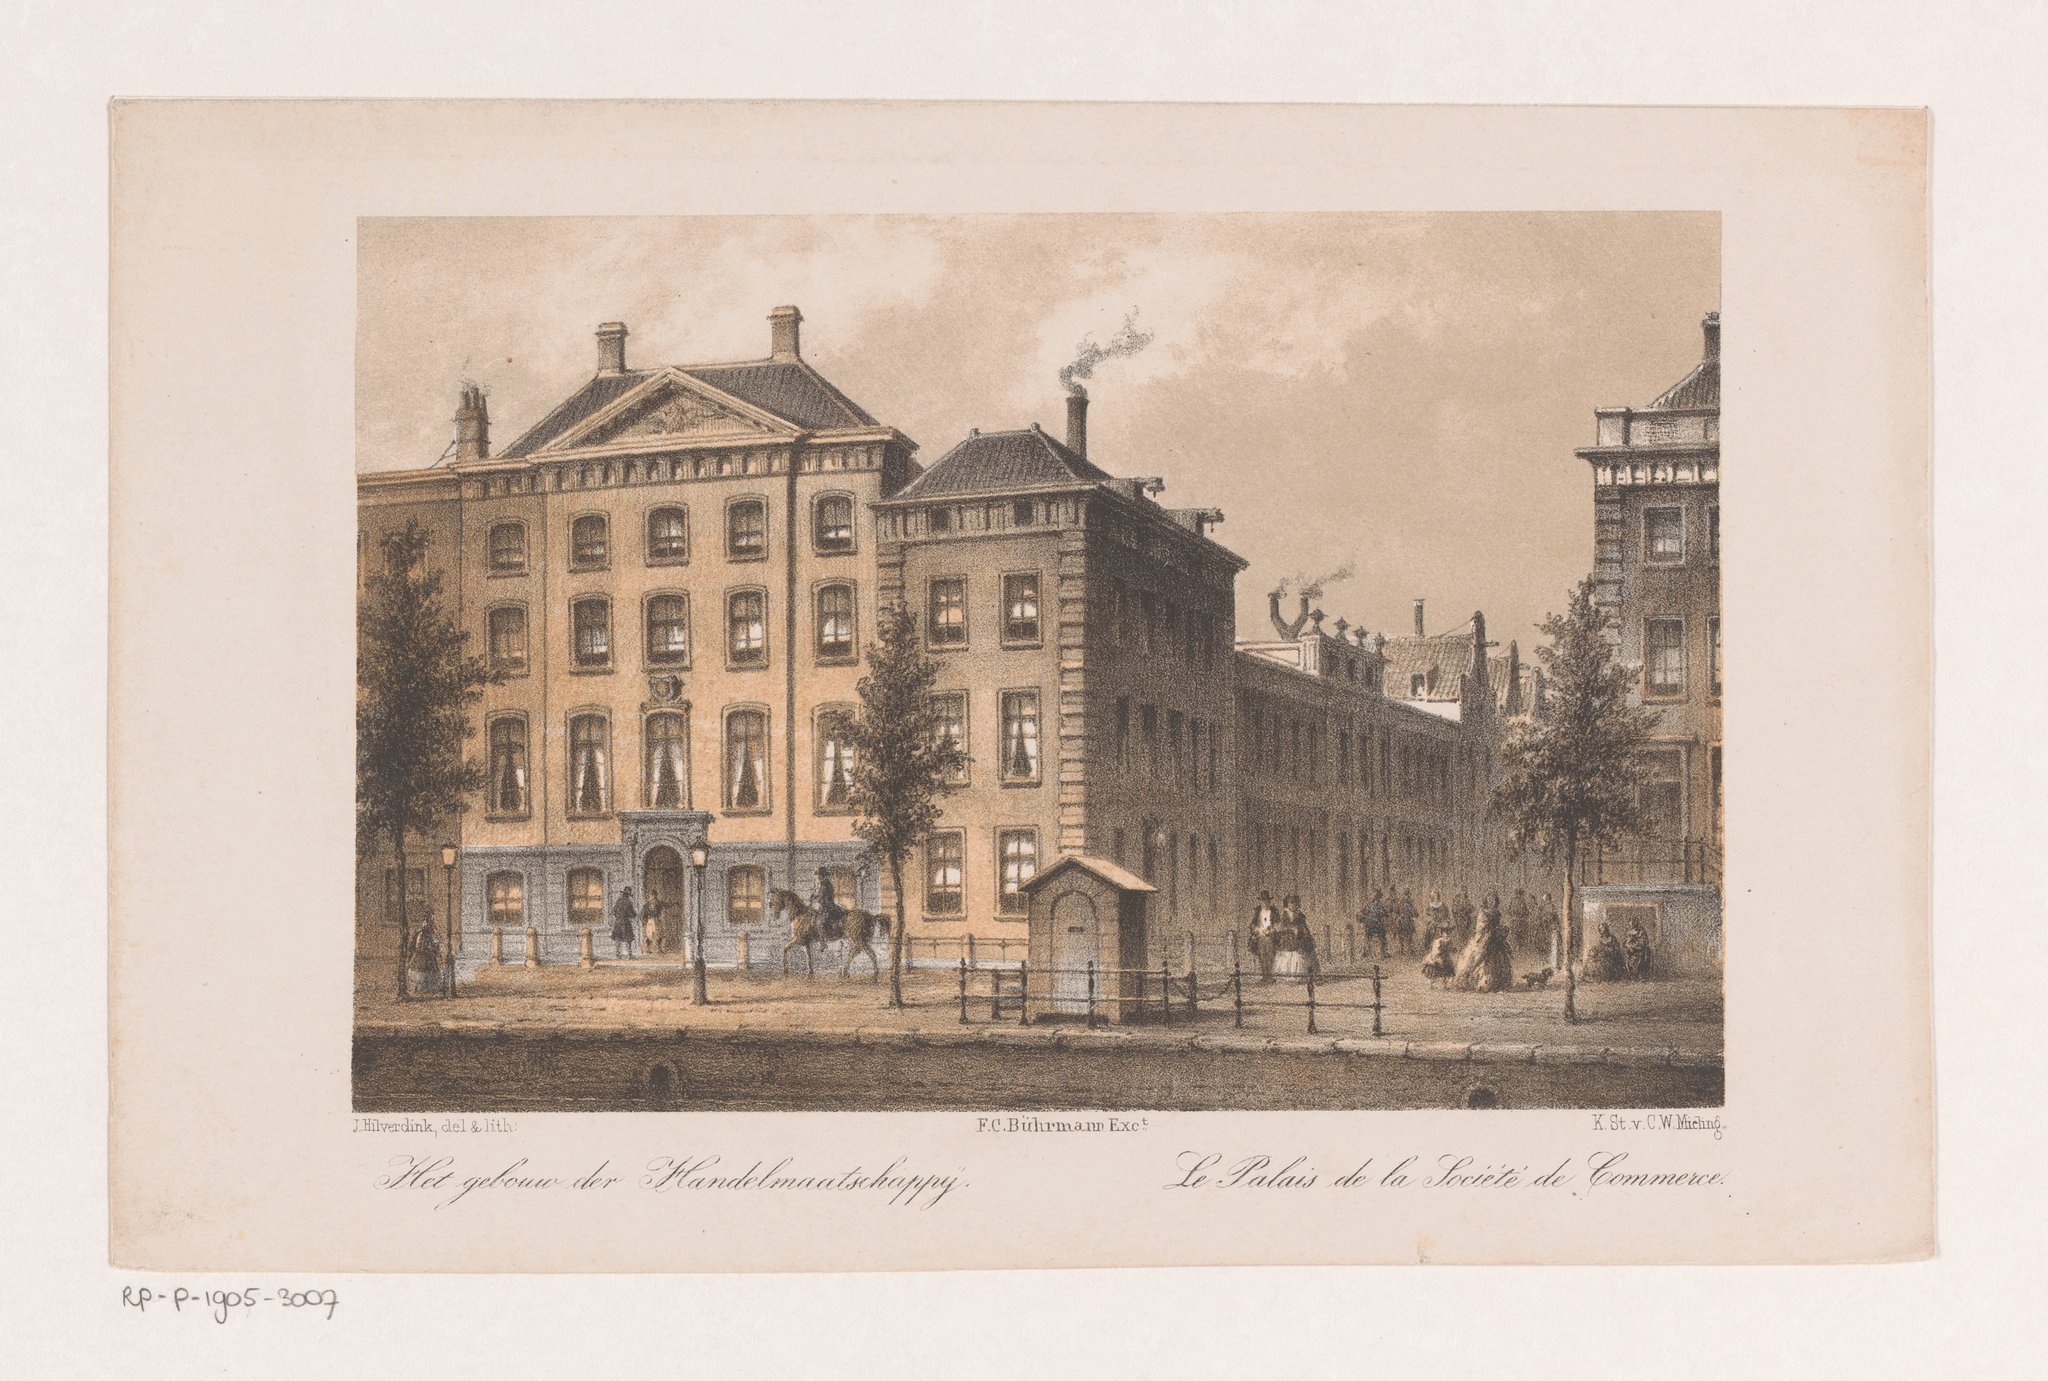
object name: print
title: Het gebouw der Handelmaatschappij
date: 1847-1863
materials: paper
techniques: lithograph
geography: the hague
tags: street (+ city(-scape) with figures, staffage), amsterdam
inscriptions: collector's mark: Lugt 2228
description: Het kantoor was gelegen aan de Herengracht 446, op de hoek met de Nieuwe Spiegelstraat. Op straat lopen figuren.